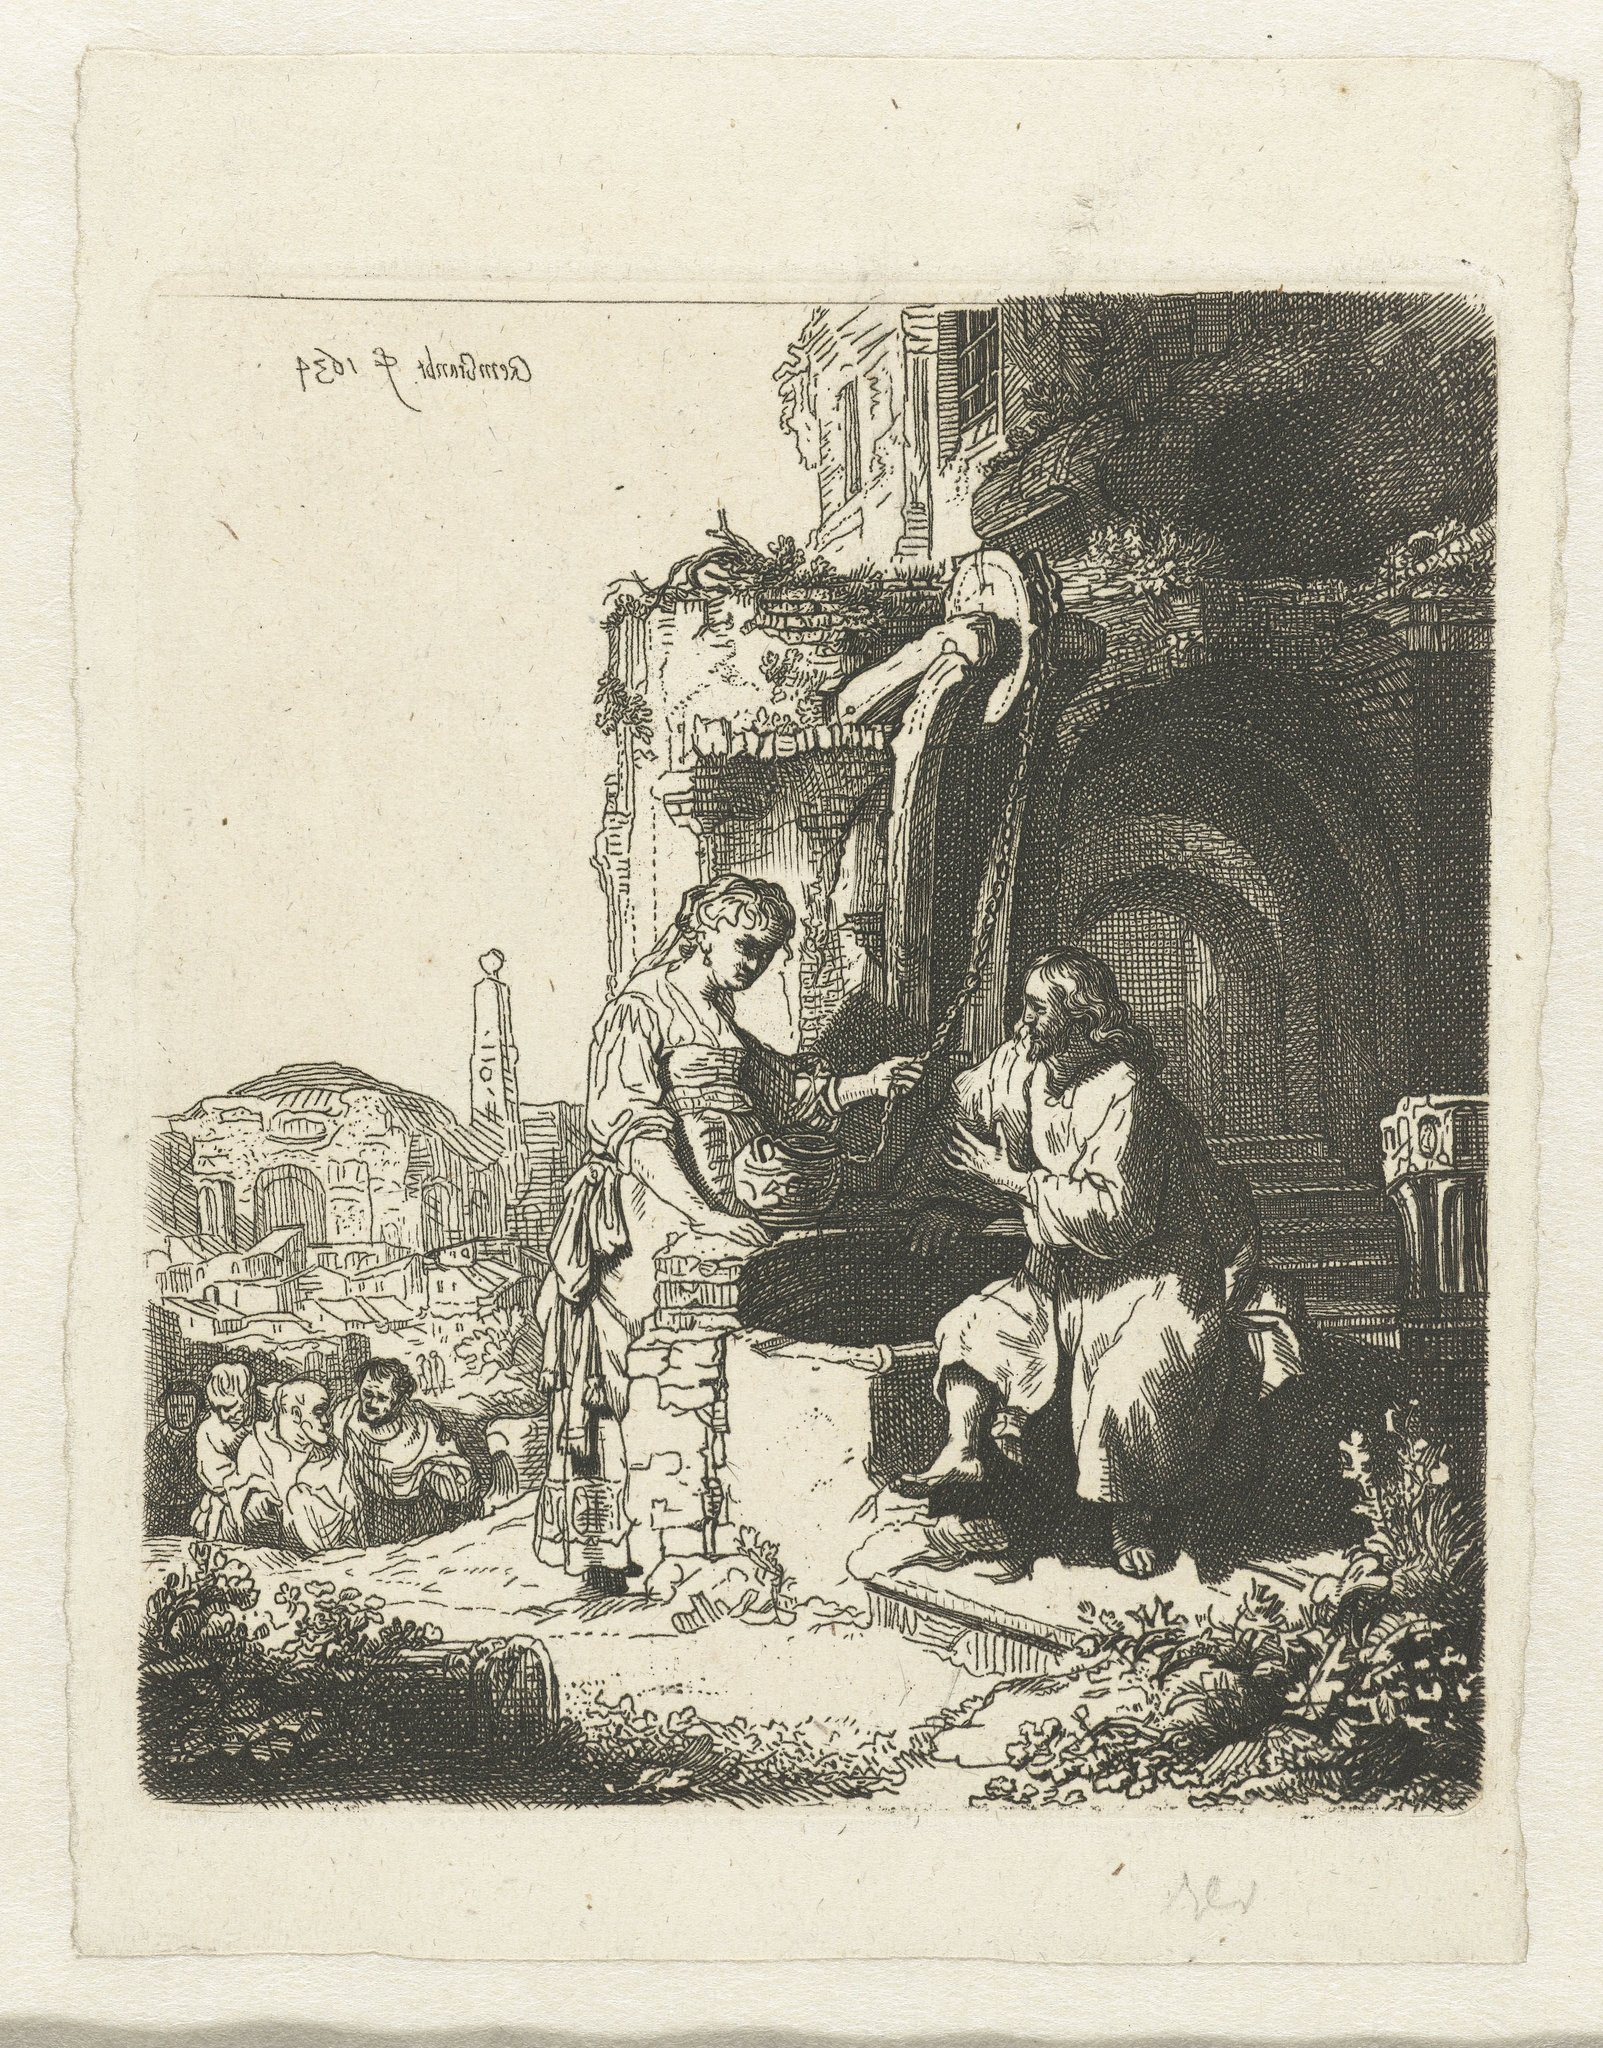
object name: print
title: Christ and the woman of Samaria among ruins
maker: john smith of chichester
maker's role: print maker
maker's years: 1717-1764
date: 1727-1764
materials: paper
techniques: etching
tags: christ and the woman of samaria: sitting at jacob's well he asks her for a drink from her jug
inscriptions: collector's mark: Lugt 2228, collector's mark: Lugt 2760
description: Spiegelbeeldige kopie naar de gelijknamige prent van Rembrandt.